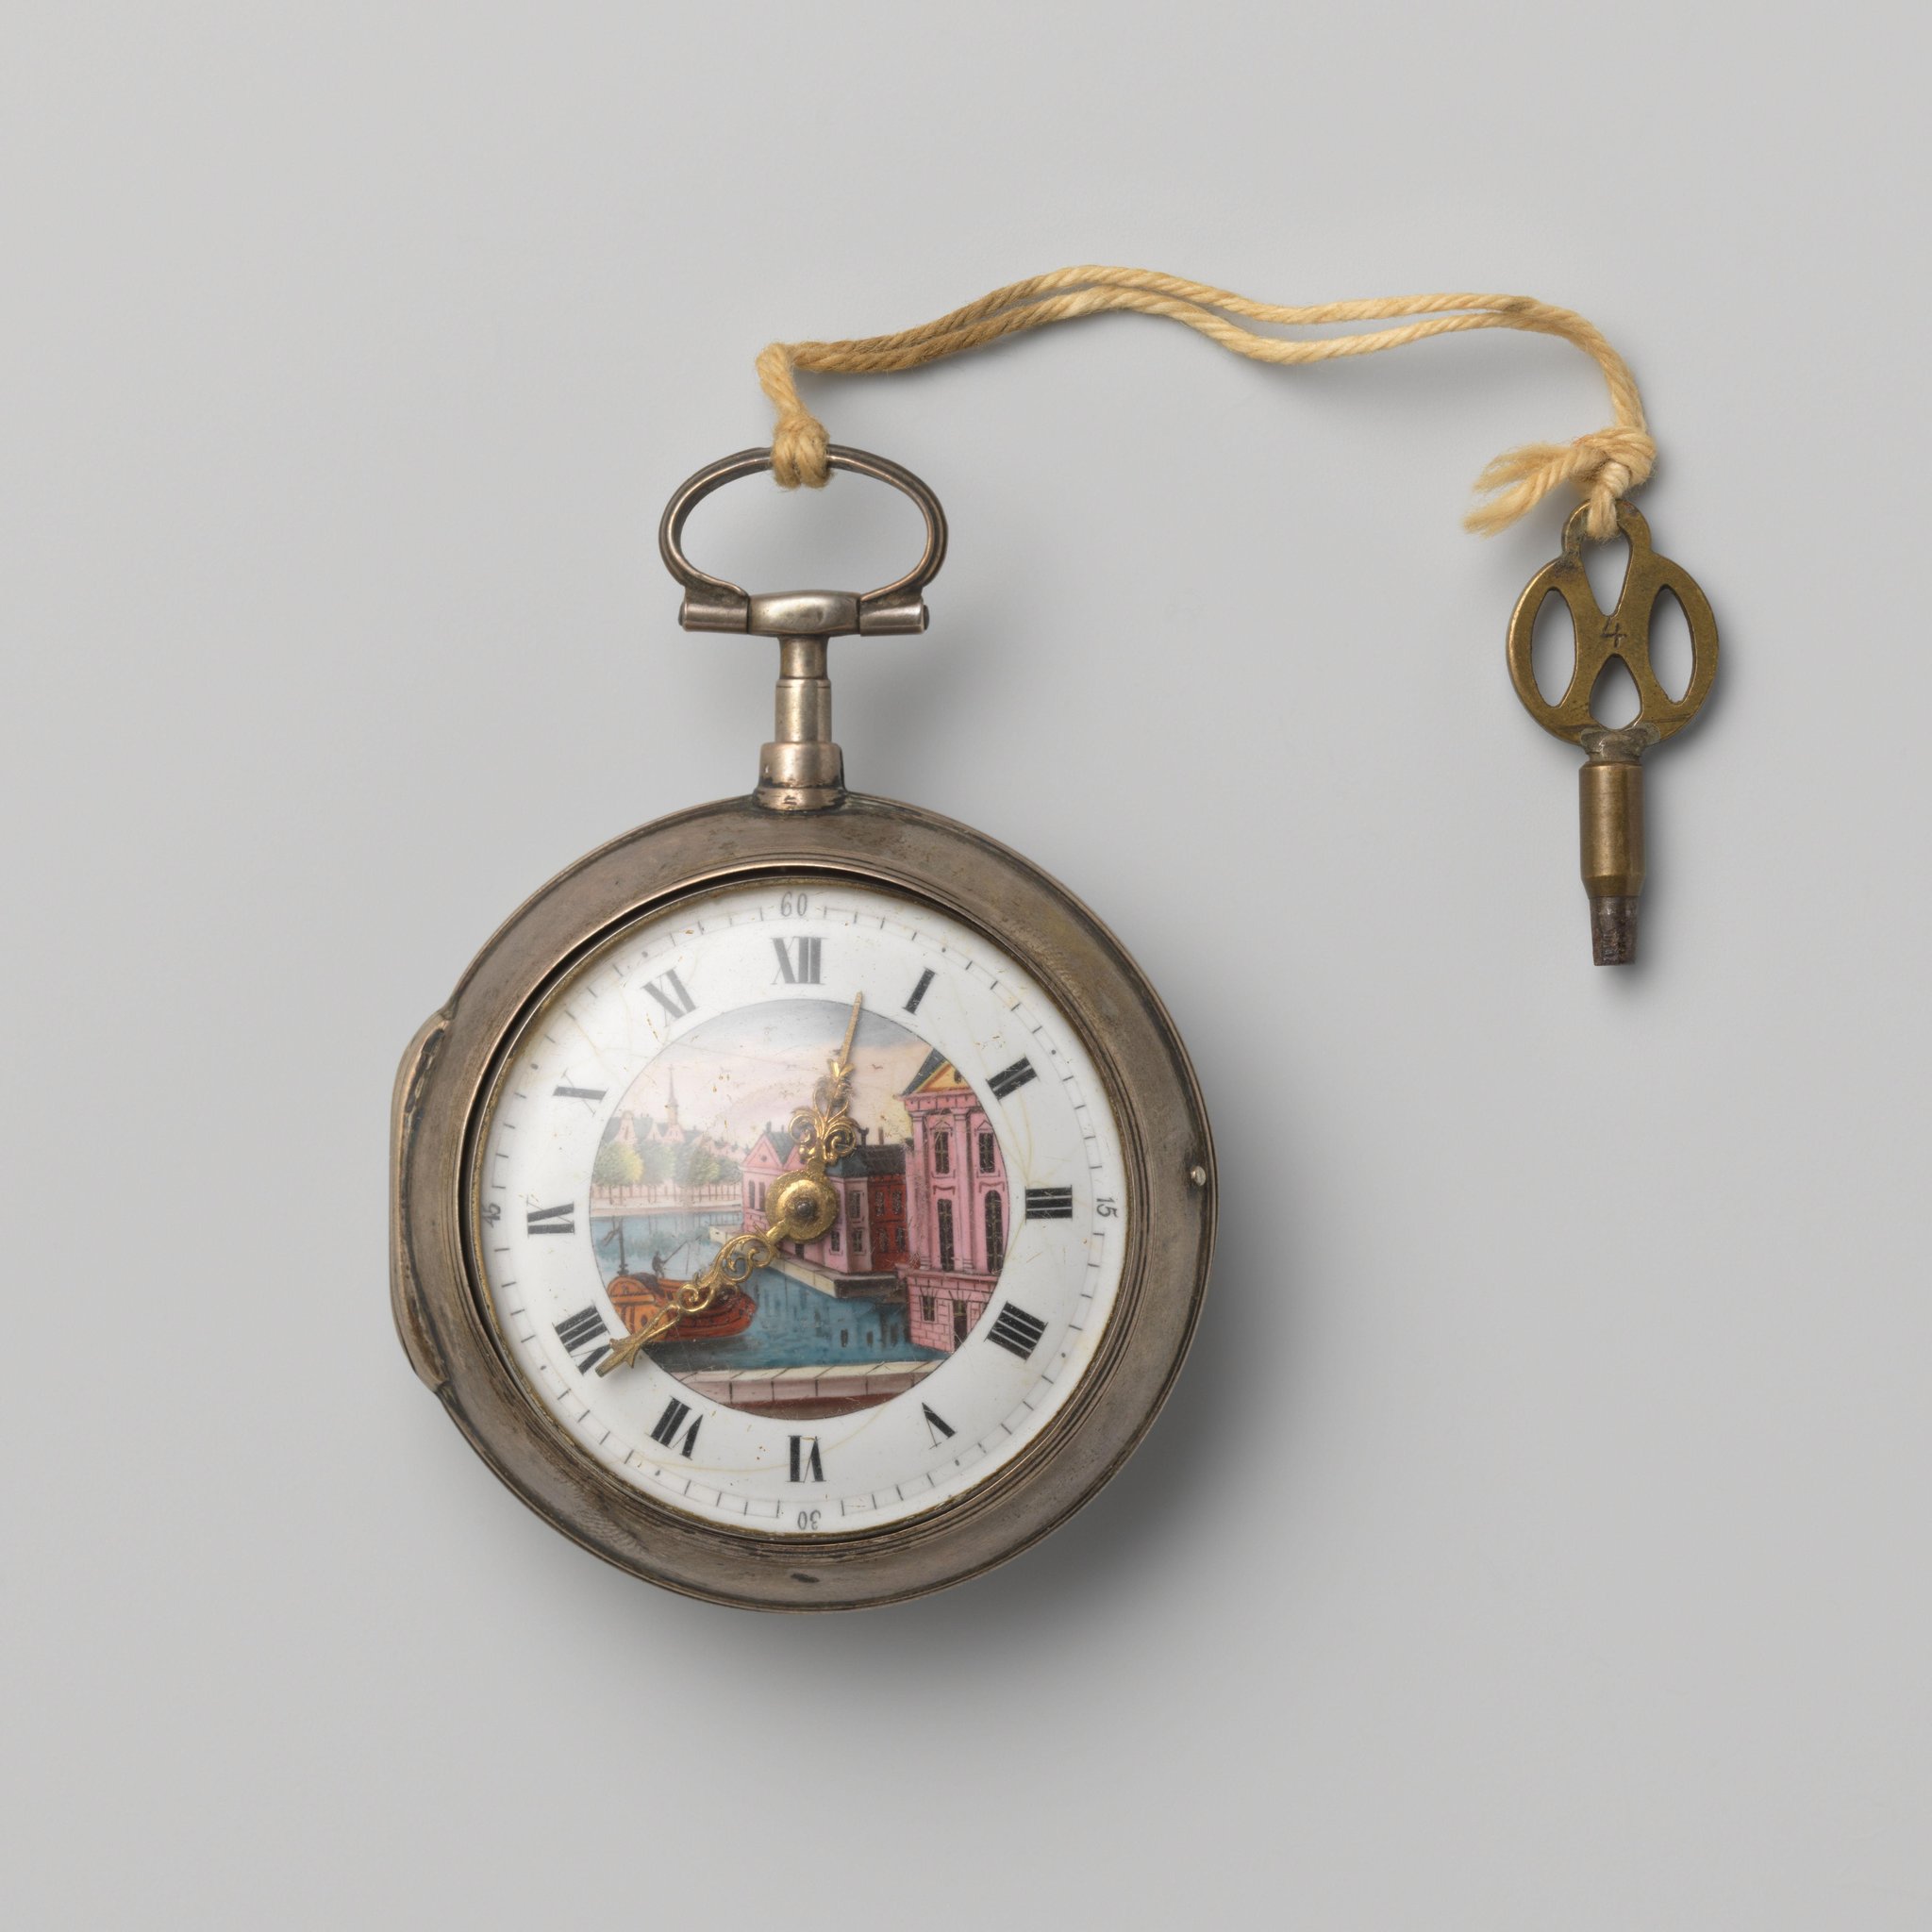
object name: wrist watch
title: herenhorloge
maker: samson (uurwerkmaker)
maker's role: clockmaker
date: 1770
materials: silver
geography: london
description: Herenhorloge van zilver met een onversierde, gladde binnen- en buitenkast. Op de geëmailleerde wijzerplaat een stadsgezicht met water in kleuren op een wit fond. Met sleuteltje.